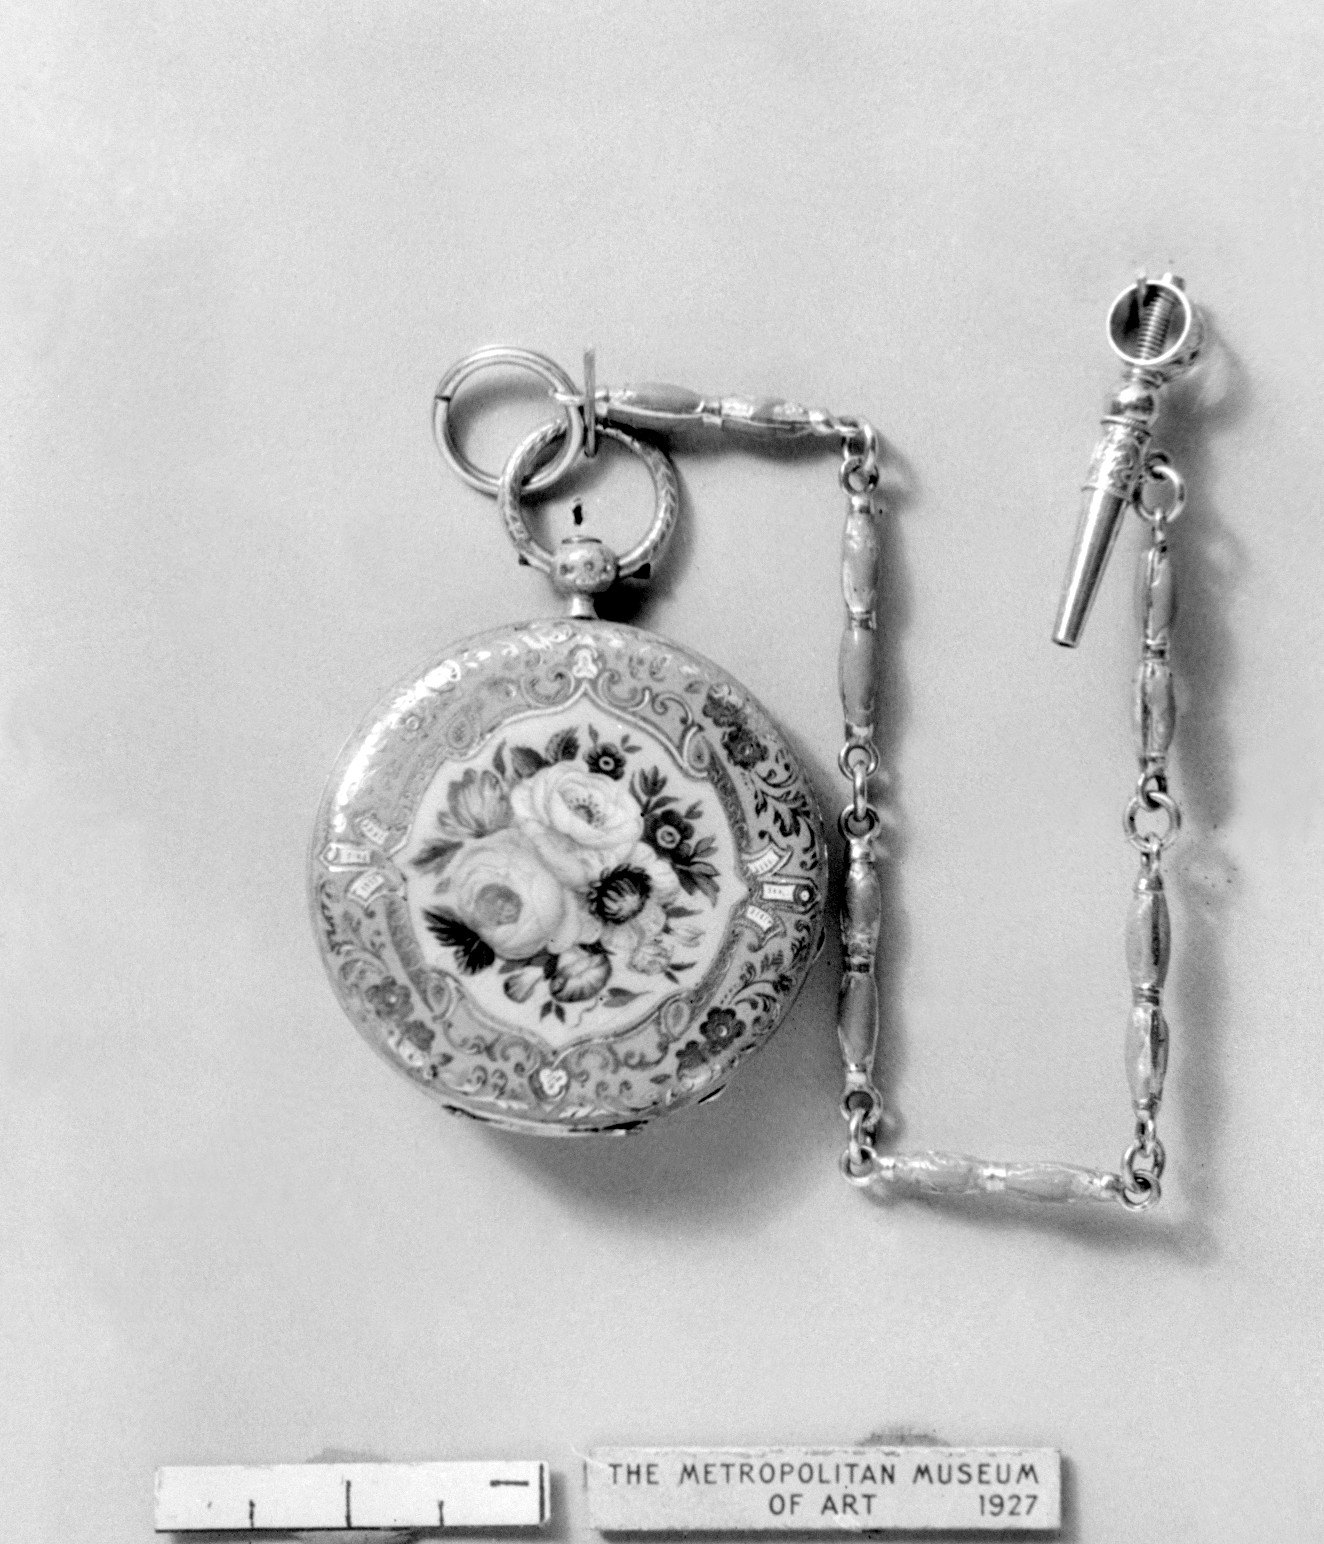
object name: watch with key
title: Watch and key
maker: s. reymond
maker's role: maker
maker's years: 1835-1845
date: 1826-1850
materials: enamel, gold, steel